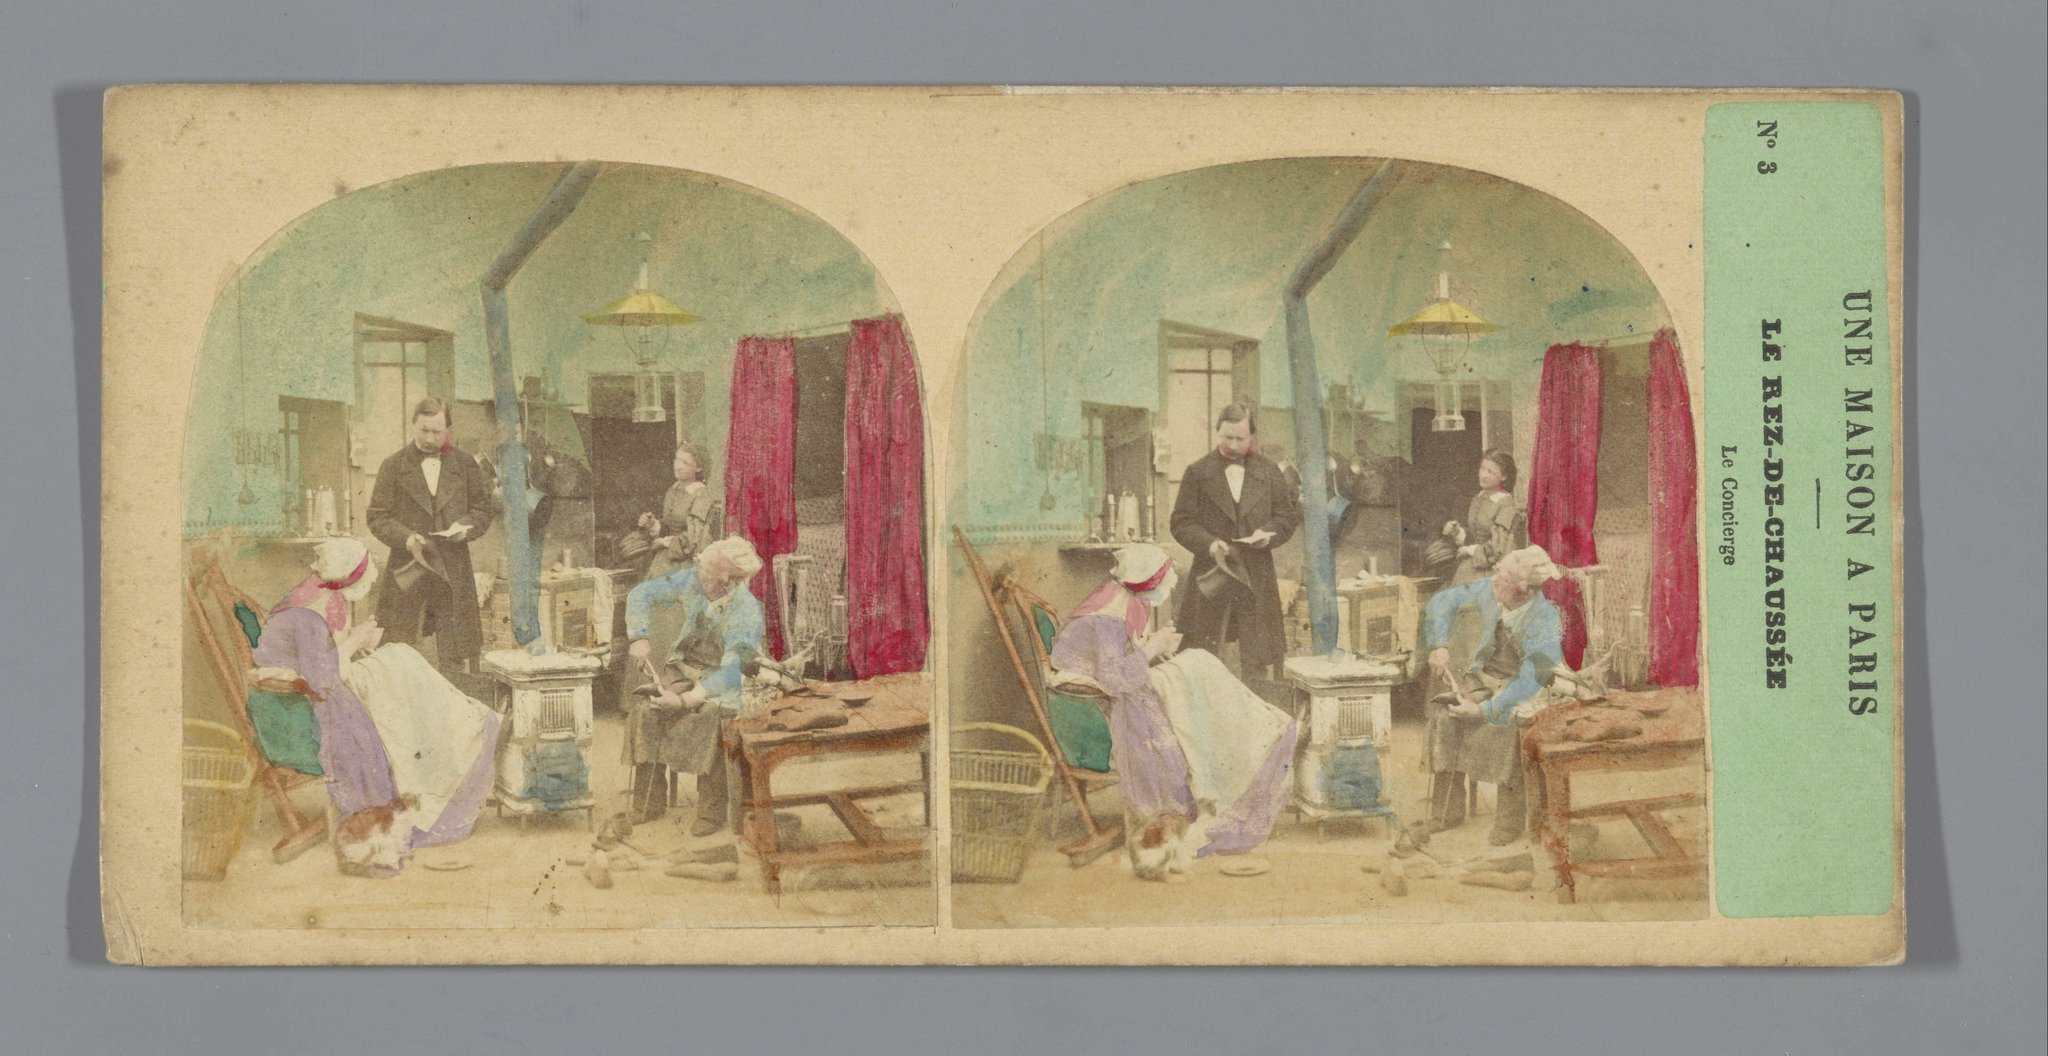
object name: stereograph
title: Une maison à Paris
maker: Anonymous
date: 1852-1863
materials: cardboard, paper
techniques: albumen print, hand coloring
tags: family life at home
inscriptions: number: ‘3’